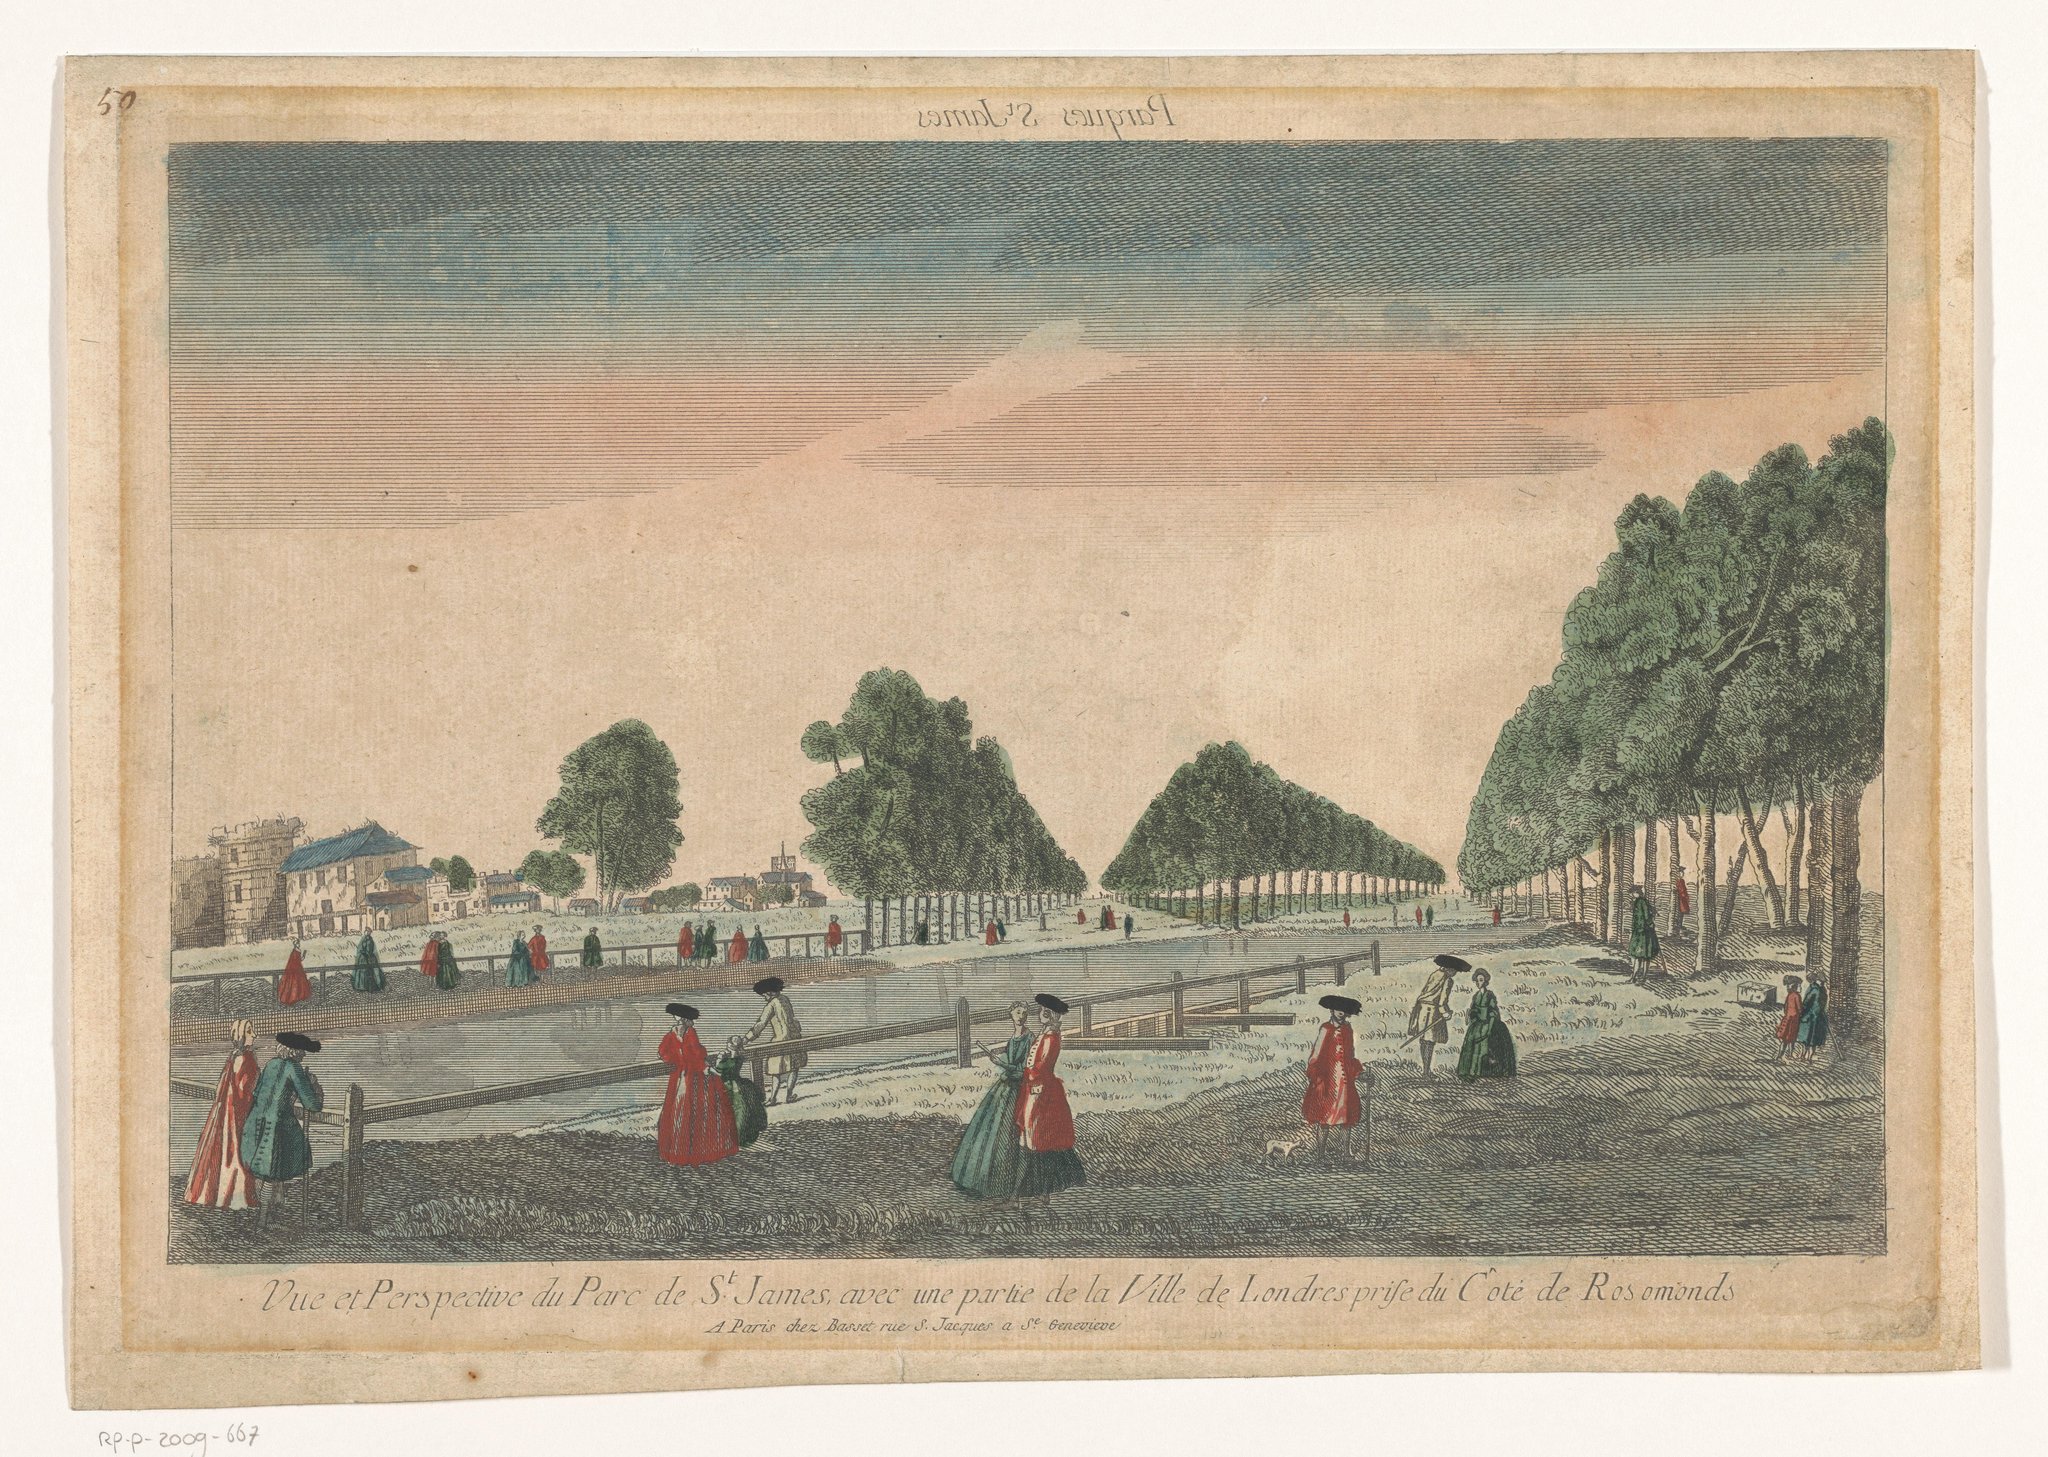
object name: print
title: Parques St James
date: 1700-1799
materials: paper, watercolor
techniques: brush, etching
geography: paris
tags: st james's park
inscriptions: collector's mark: Lugt 2228, watermark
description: Gezicht op Rosemonds Pond en lange bomenrijen in het park St James in Londen, met wandelende paren. Links een ruïne van een huis met een ronde toren.